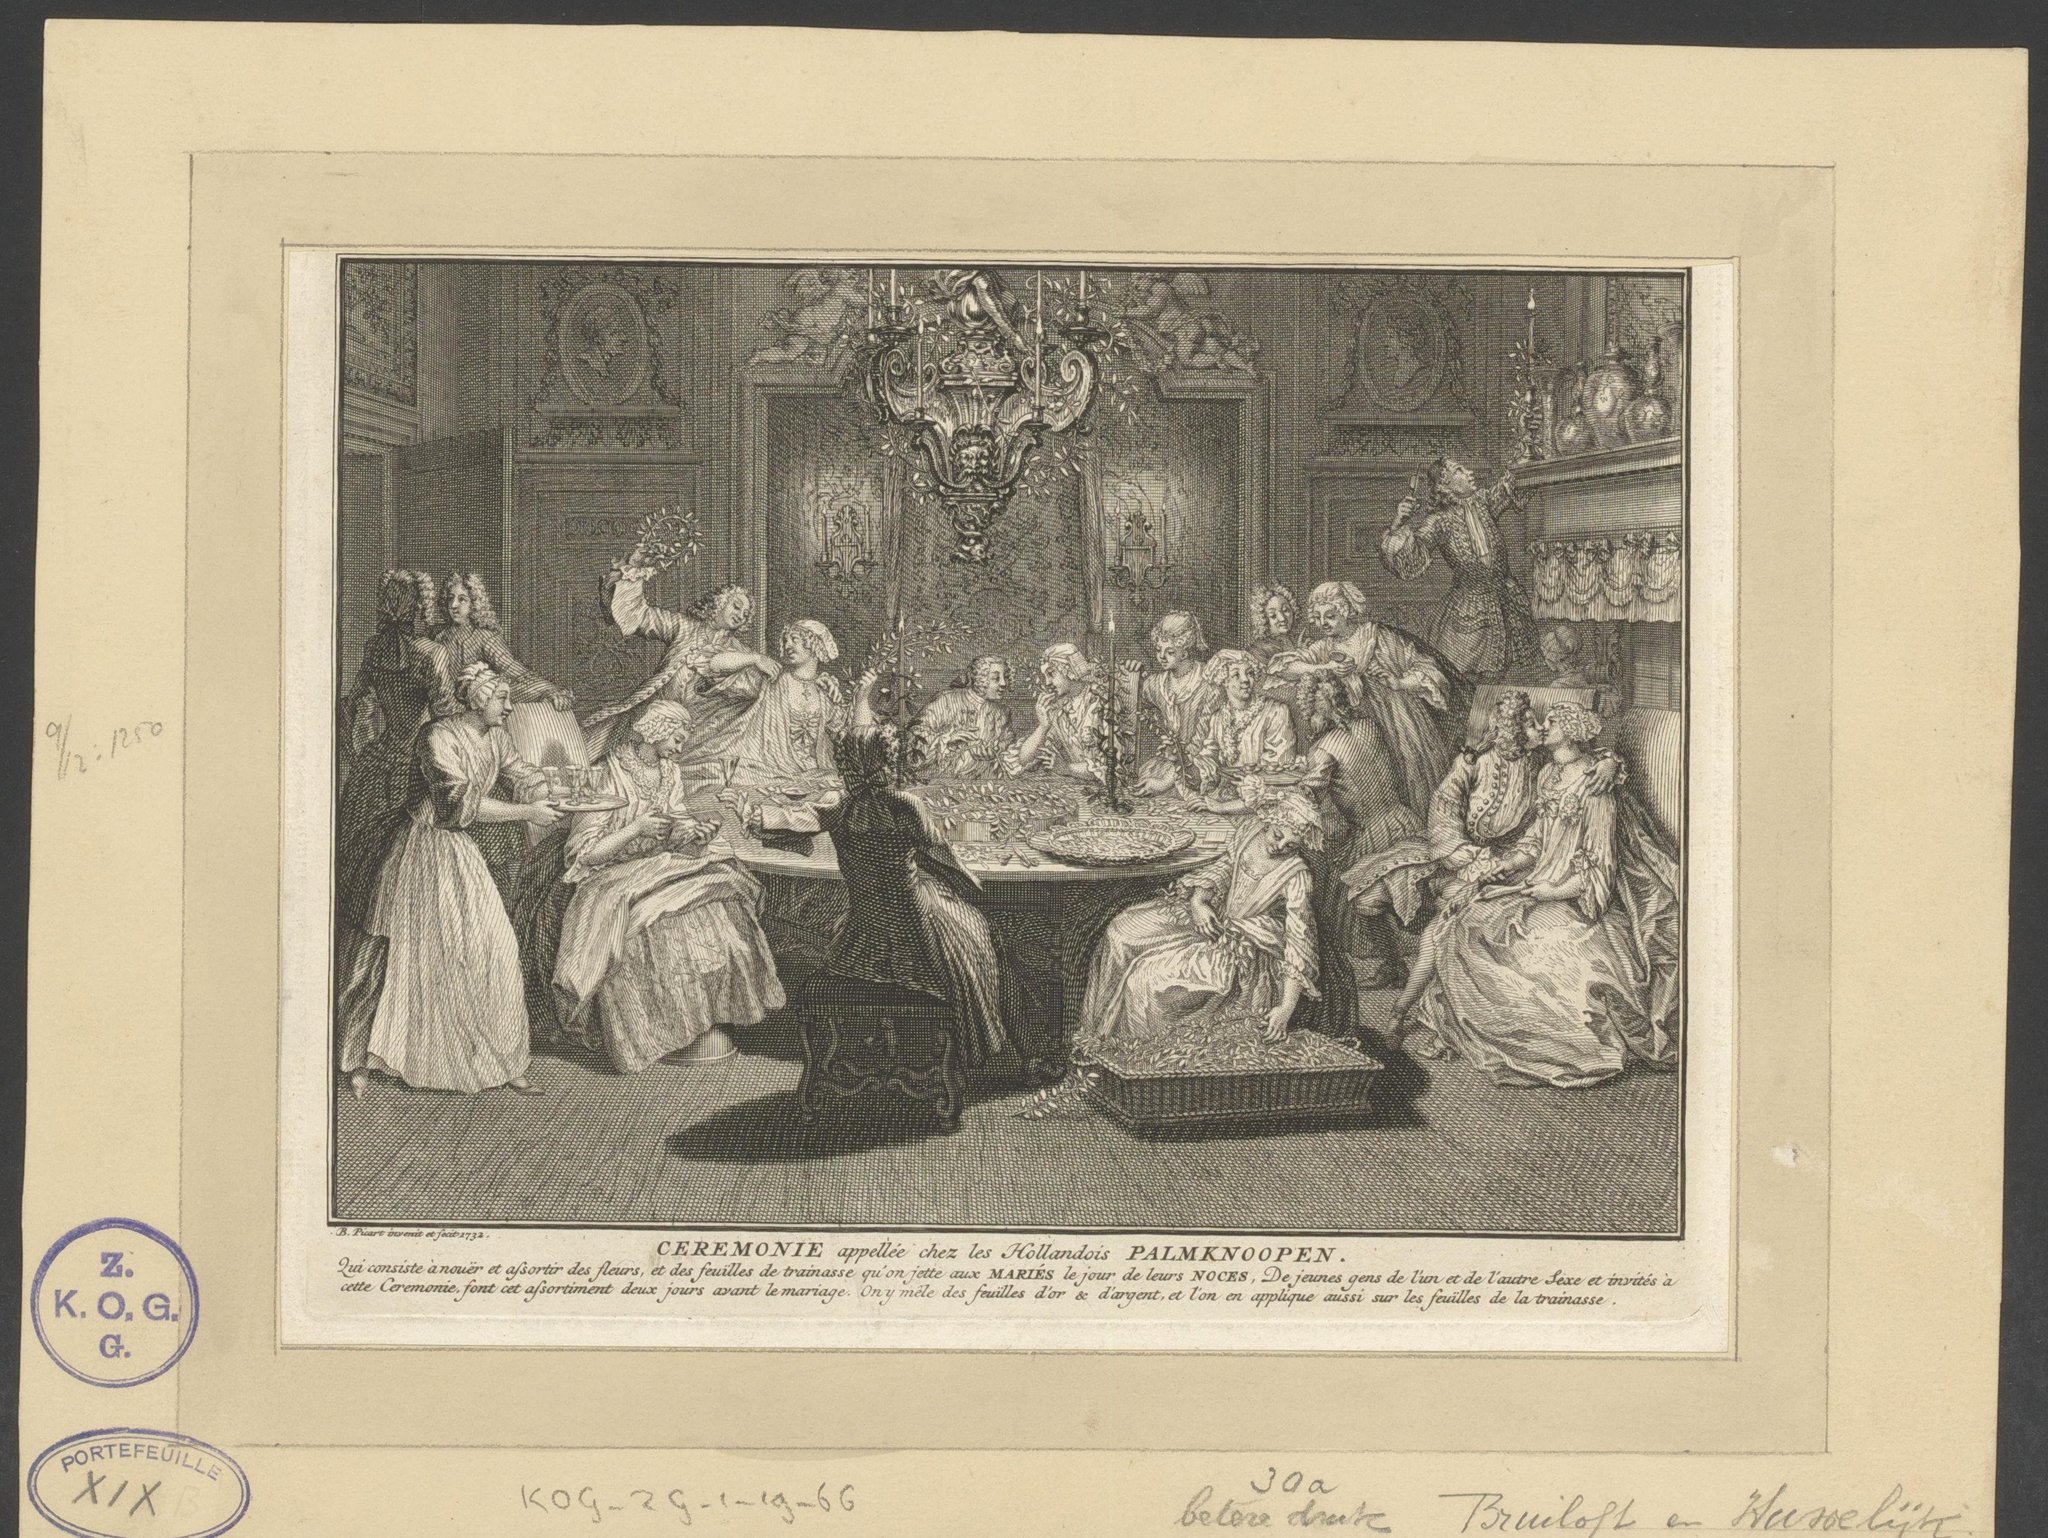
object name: book illustration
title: Palmknopen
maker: bernard picart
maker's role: draughtsman, print maker, publisher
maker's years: 1673-1733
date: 1732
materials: paper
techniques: engraving, etching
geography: netherlands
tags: betrothal, amsterdam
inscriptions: collector's mark, collector's mark: Lugt 1641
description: Voorstelling over huwelijksgebruiken bij de hervormden in Amsterdam, ca. 1730. Voorstelling van het palmknopen, het knopen van bloemen- en bladerkransen door het verloofde paar en vrienden. Met onderschrift in het Frans Onderwerpsrubrieken binnen de Atlas Zeden en Gewoonten: Des Menschen Begin, Midden en Einde. Bruiloft en huwelijk.